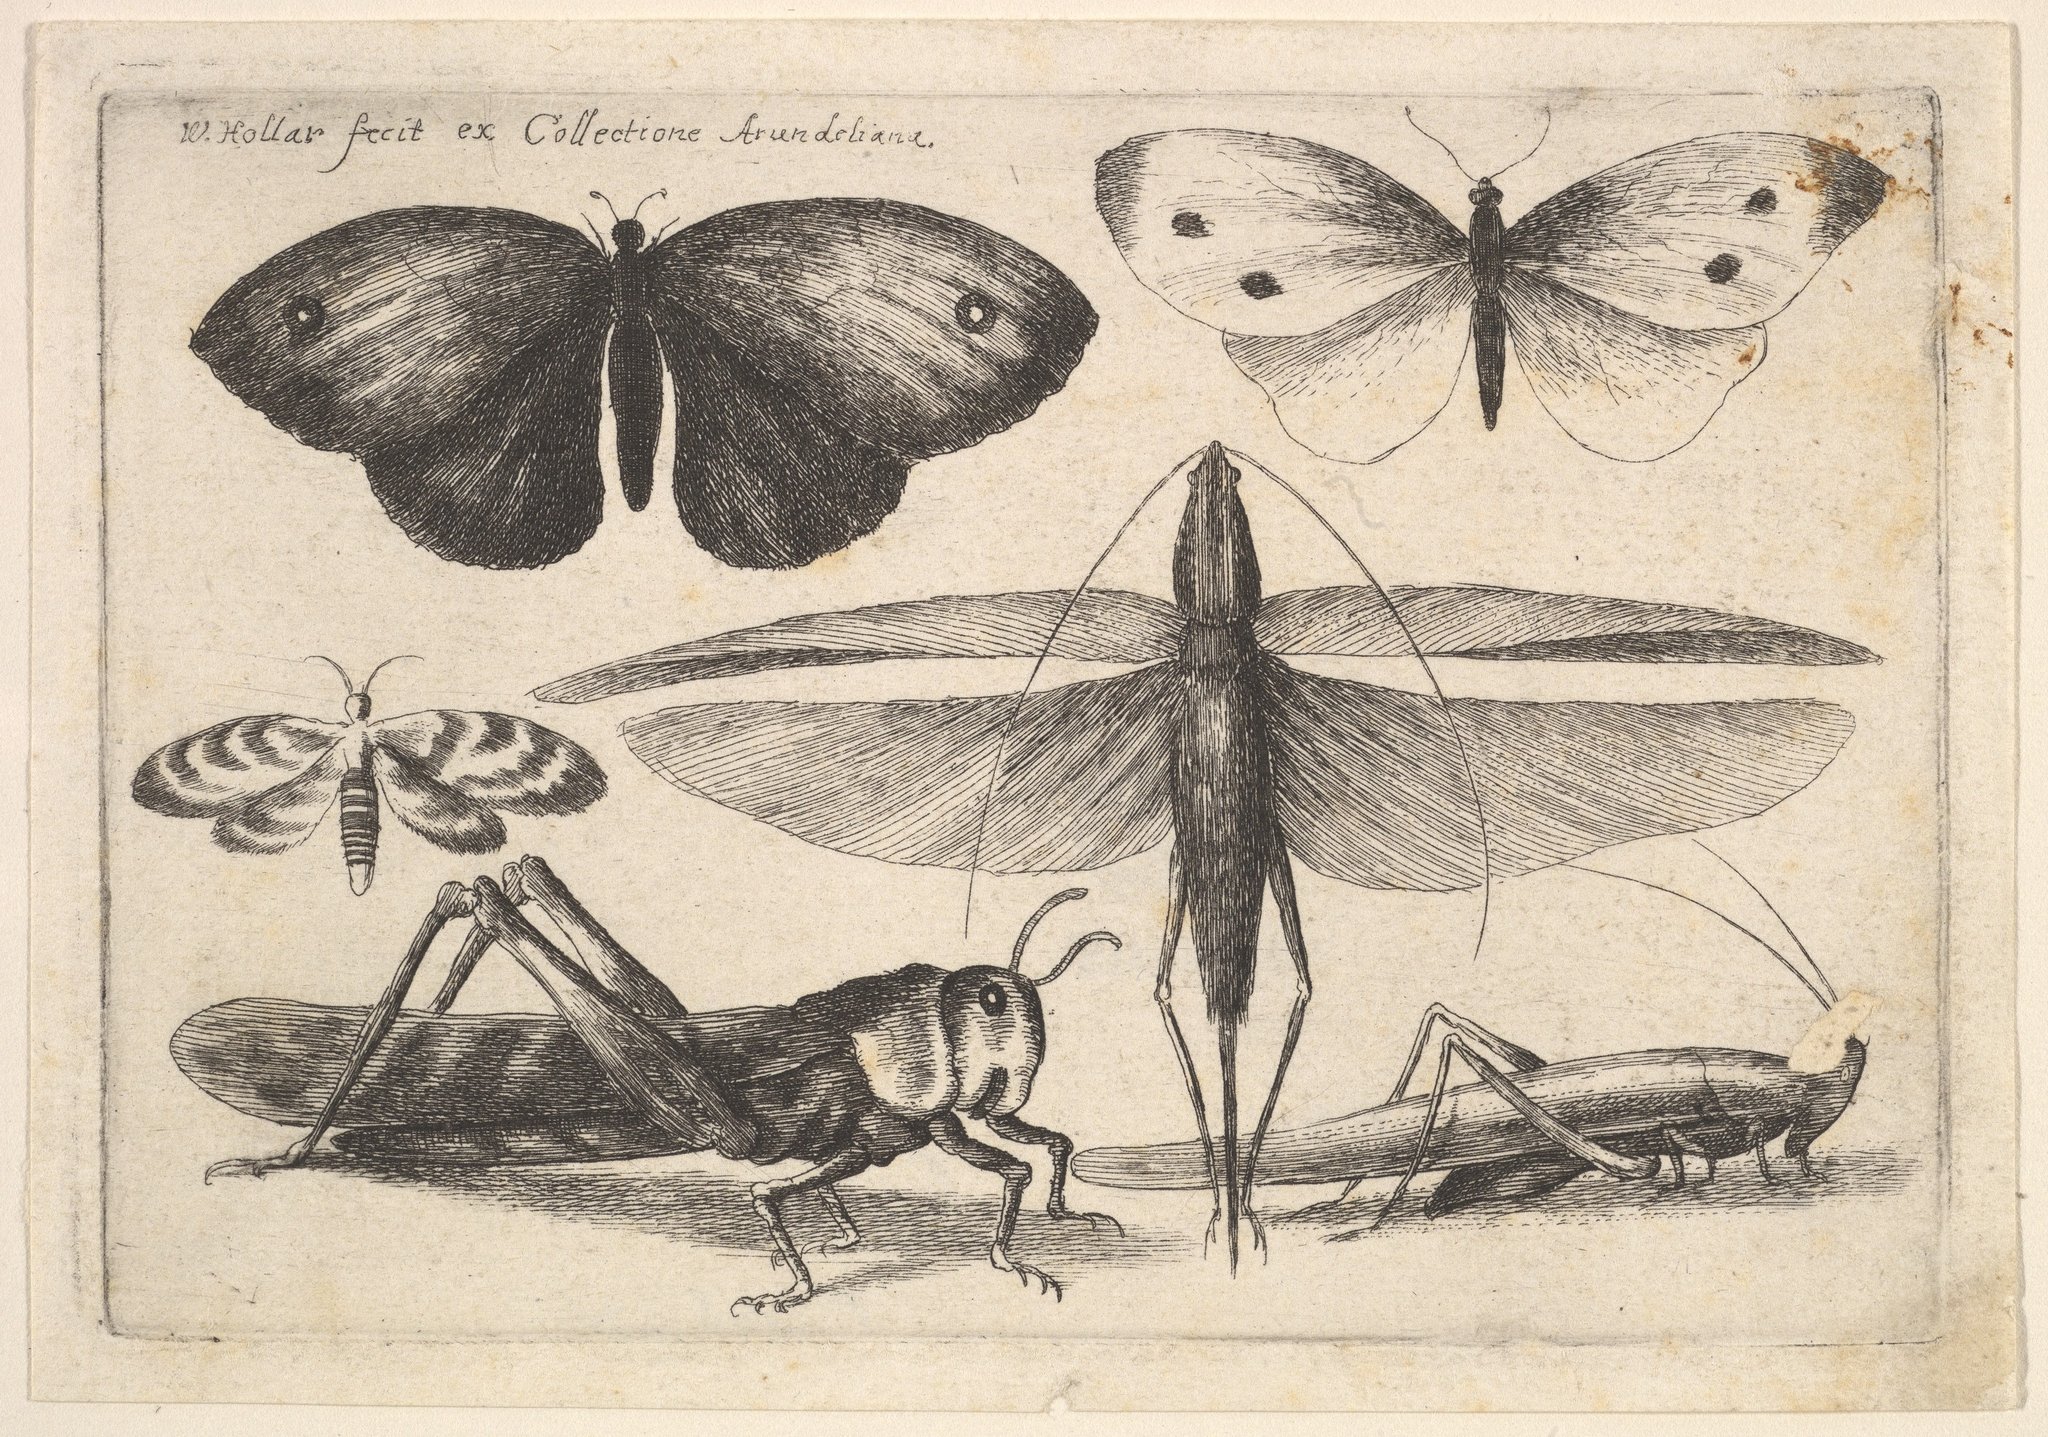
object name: print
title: Six Insects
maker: wenceslaus hollar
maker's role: artist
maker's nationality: bohemian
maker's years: 1607-1677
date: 1646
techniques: etching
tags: insects,butterflies